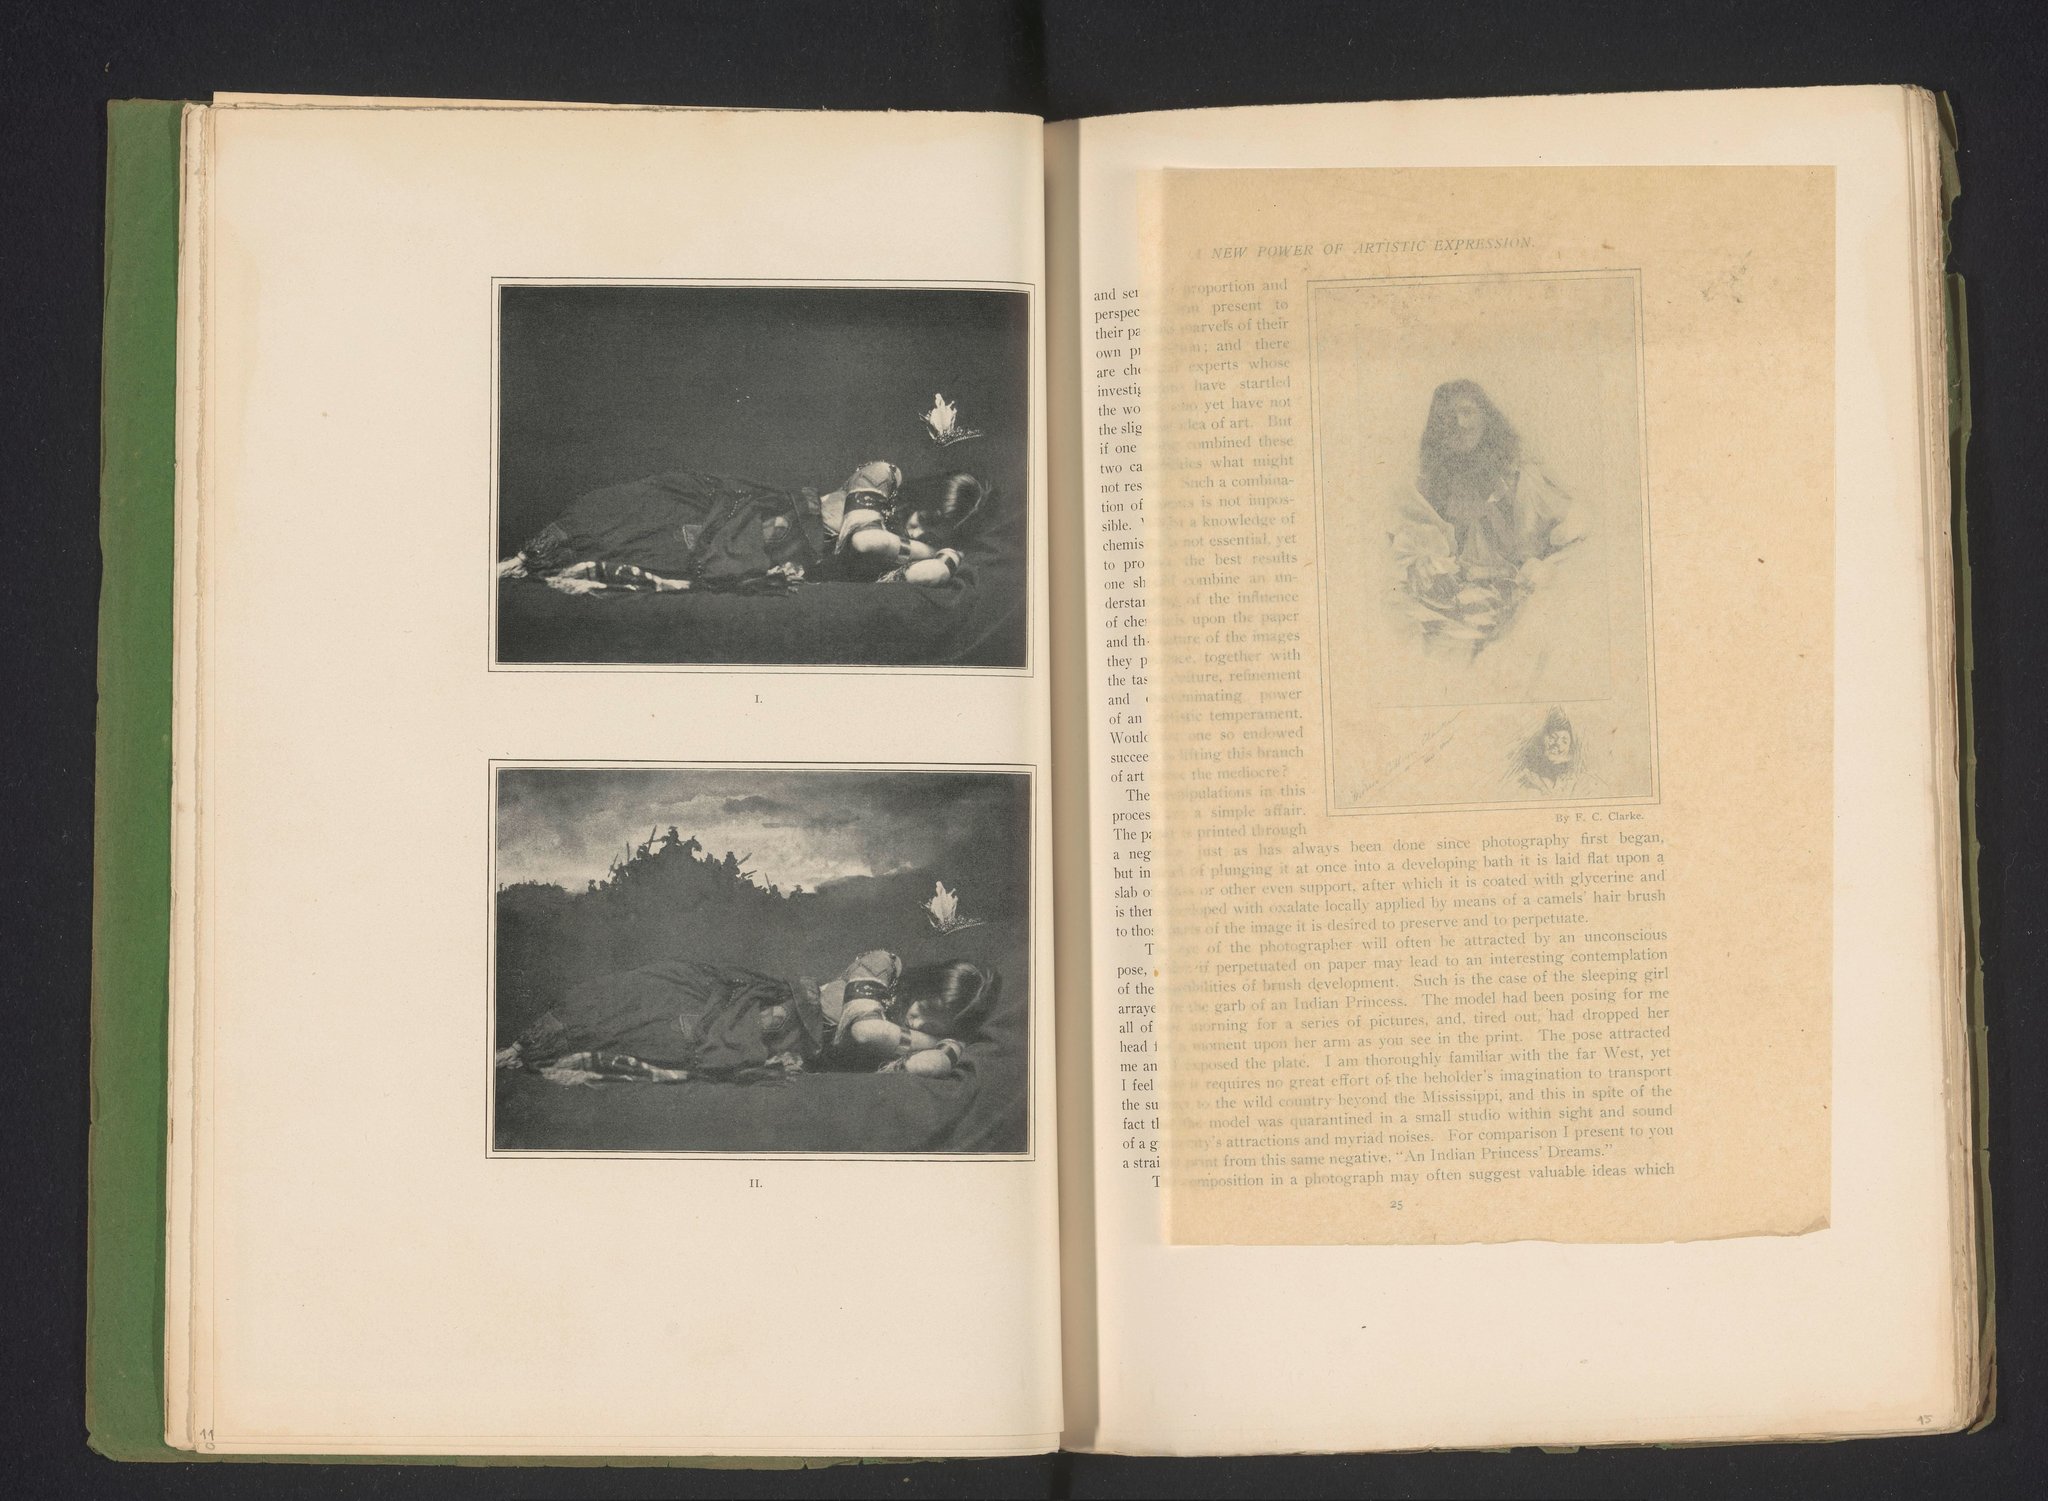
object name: photomechanical print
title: Vrouw ligt op een bed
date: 1896-1901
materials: paper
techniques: autotype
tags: adult woman, lying on one side, stretched out